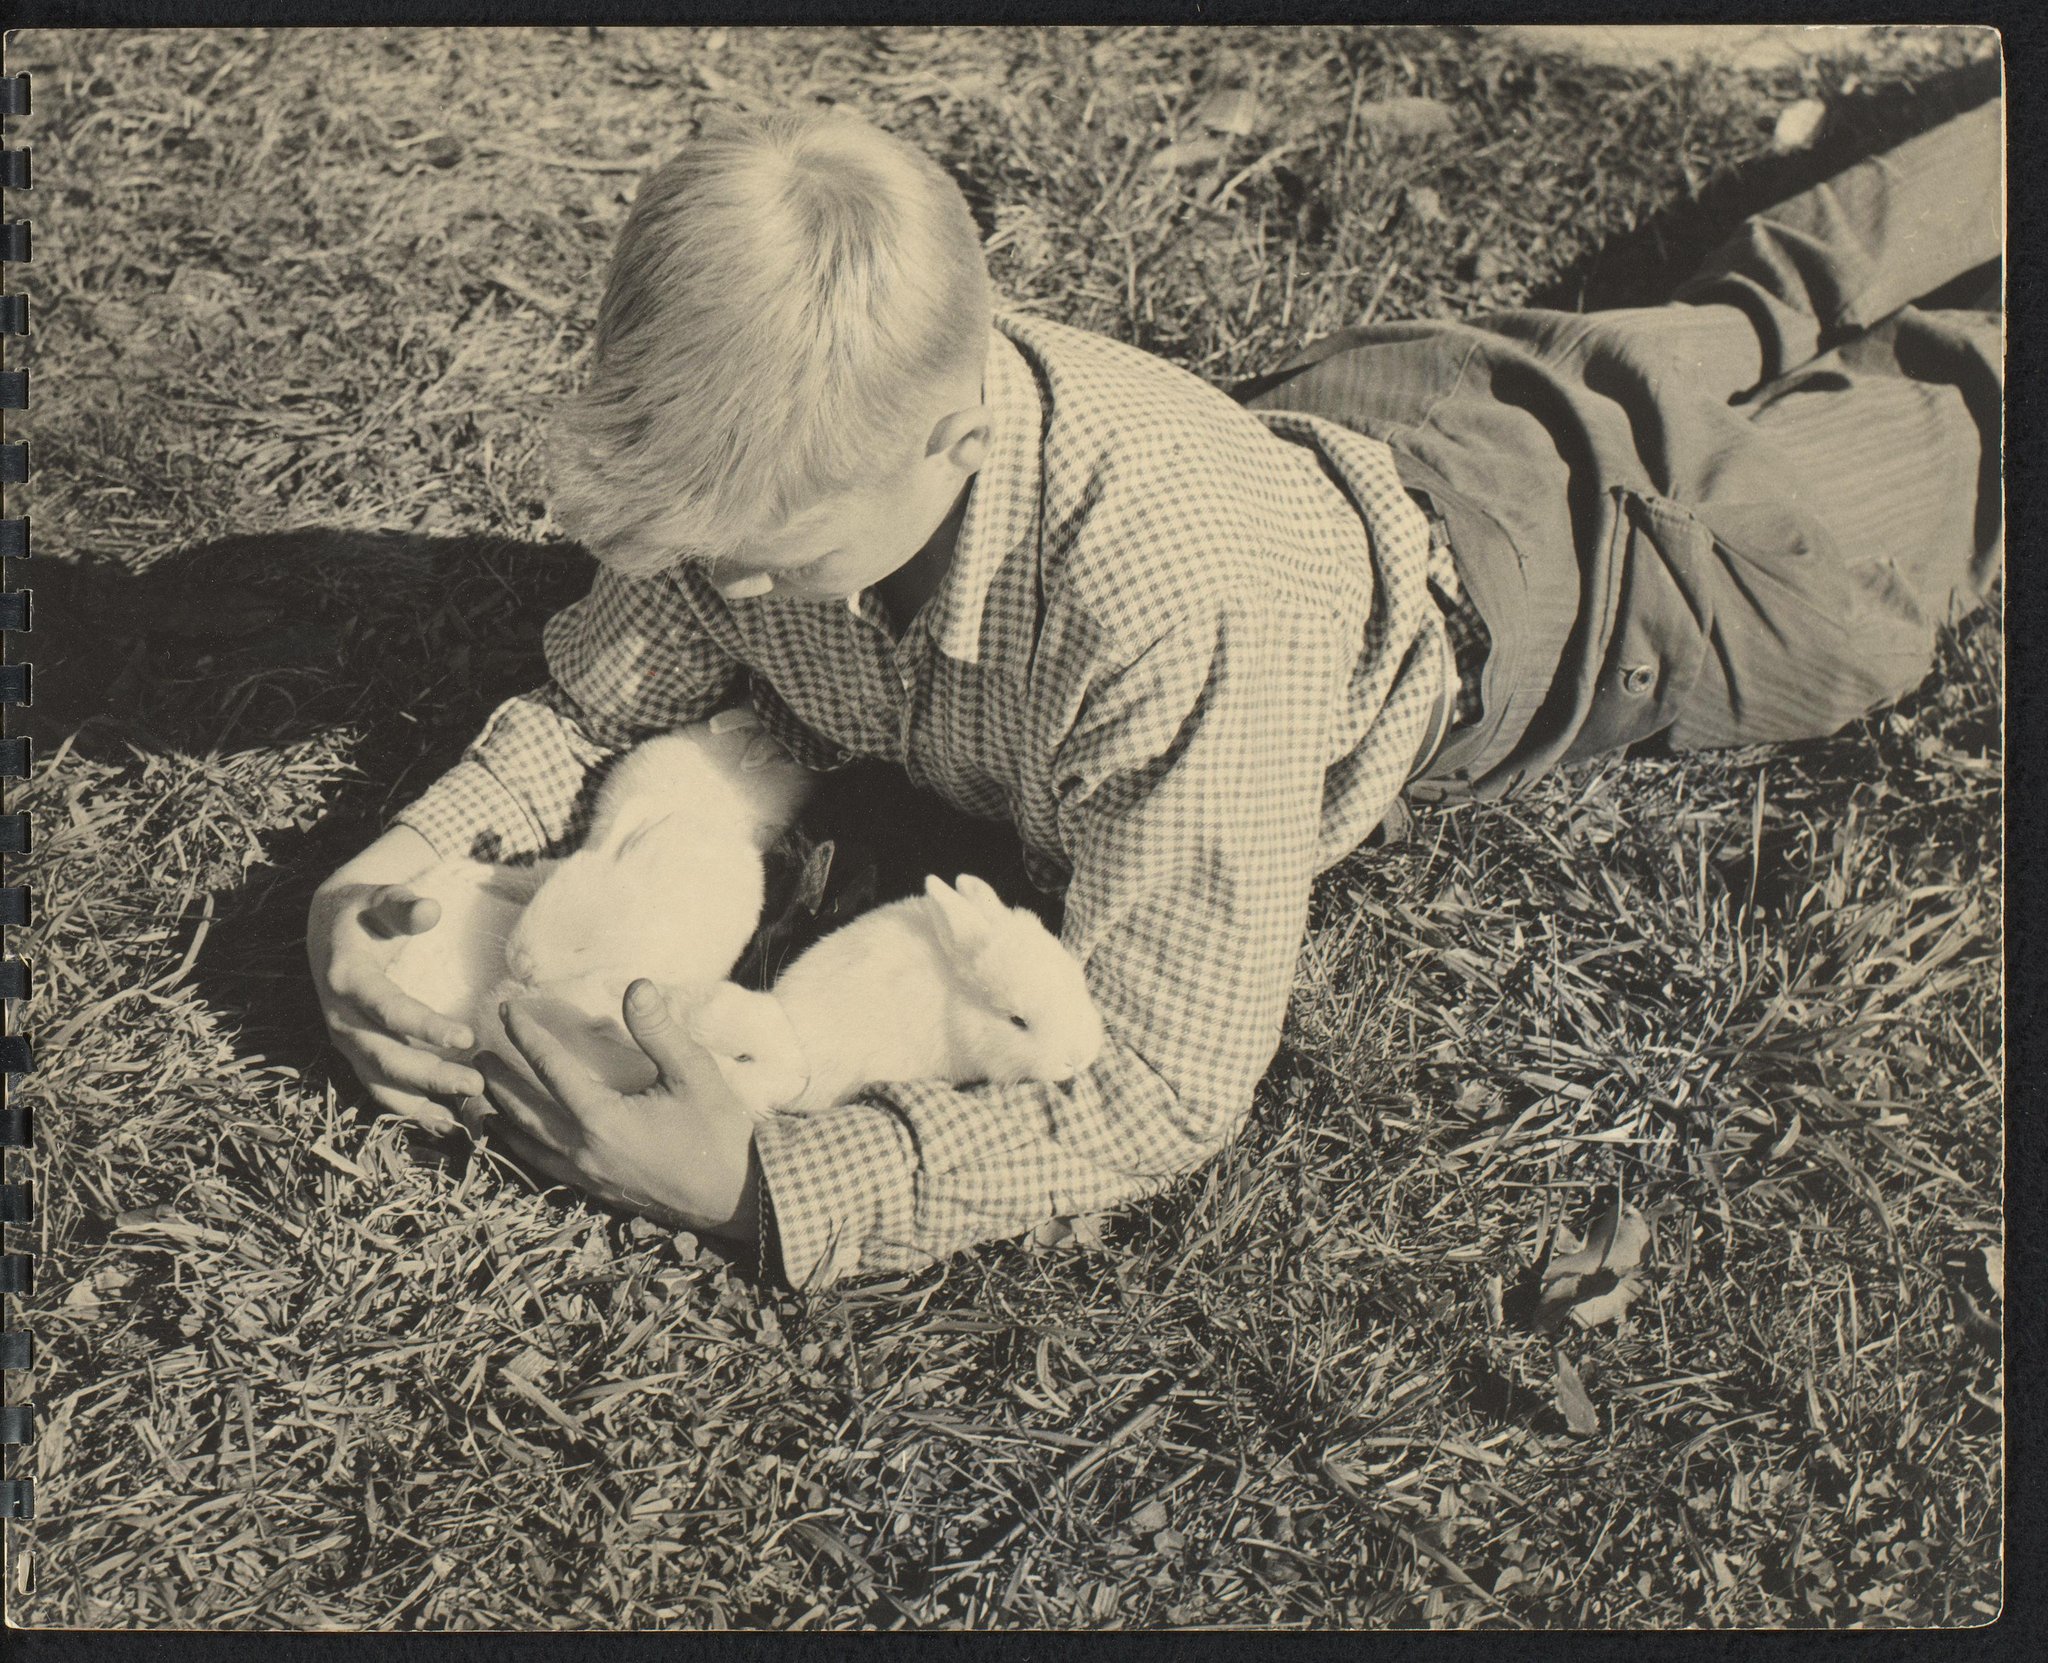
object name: photograph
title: Jongen met konijnen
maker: Anonymous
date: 1950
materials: paper, photographic support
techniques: gelatin silver print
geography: new york city